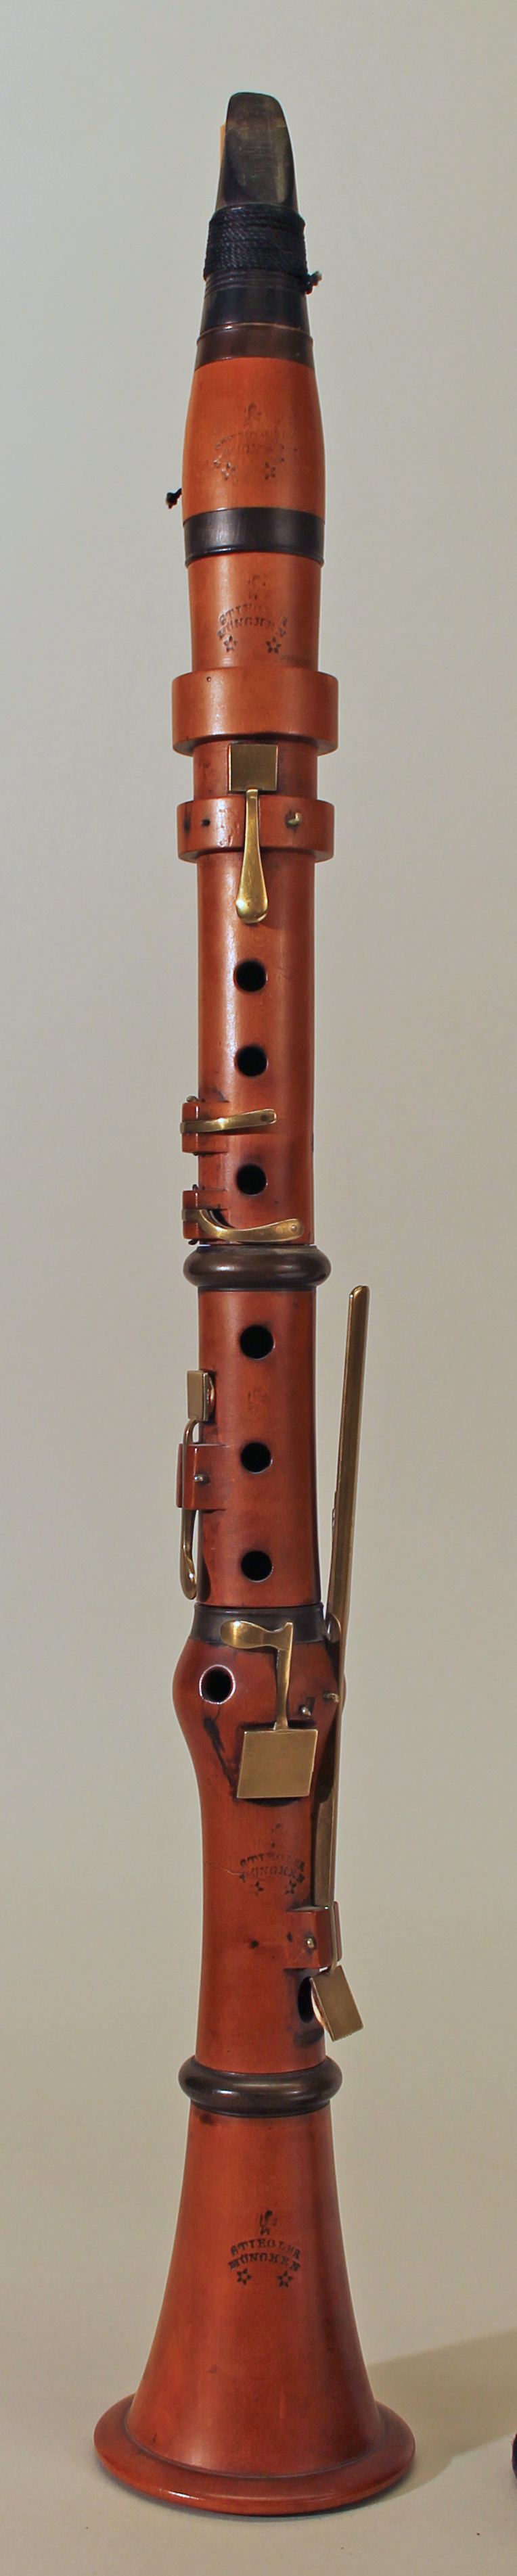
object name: sopranino clarinet in d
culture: german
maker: max stiegler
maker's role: maker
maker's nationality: german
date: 1800-1858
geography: germany